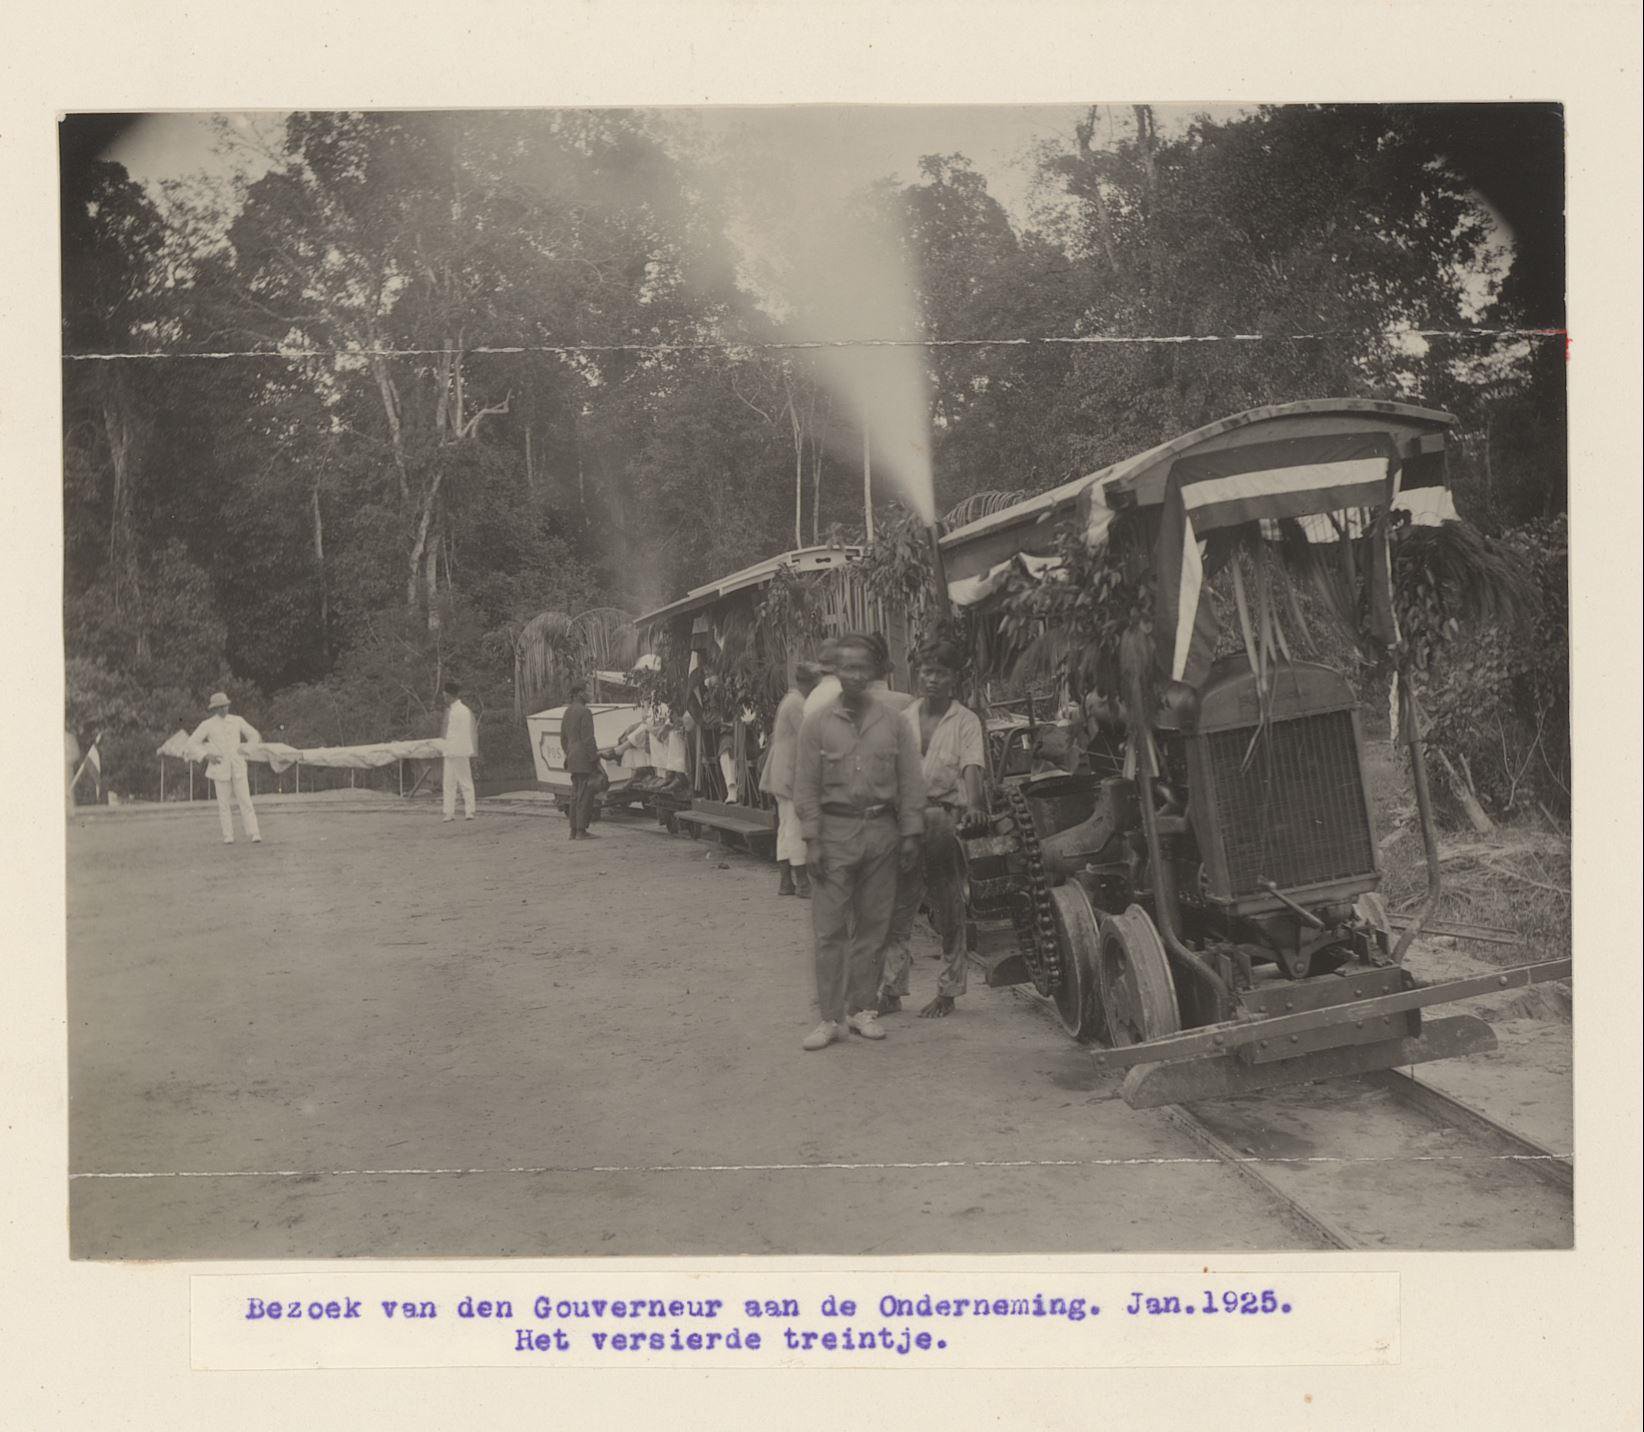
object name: photograph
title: Bezoek van den Gouverneur aan de Onderneming. Jan. 1925. Het versierde treintje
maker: Anonymous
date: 1901-1925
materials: photographic support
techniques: gelatin silver print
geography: sumatra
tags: plantation, colonial governor, (non-fruit) products of plants or trees: rubber, railway, train, sumatra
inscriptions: inscription: ‘Bezoek van den Gouverneur aan de Onderneming. Jan. 1925. Het versierde treintje’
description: Een versierd treintje op smalspoor waarmee de Gouverneur van de Oostkust van Sumatra tijdens zijn bezoek aan de onderneming is rondgeleid, januari 1925. Onderdeel van het fotoalbum over de plantages Brussel en Pernantian van de Sumatra Caoutchouc Maatschappij op de Oostkust van Sumatra in de jaren 1910-1935.